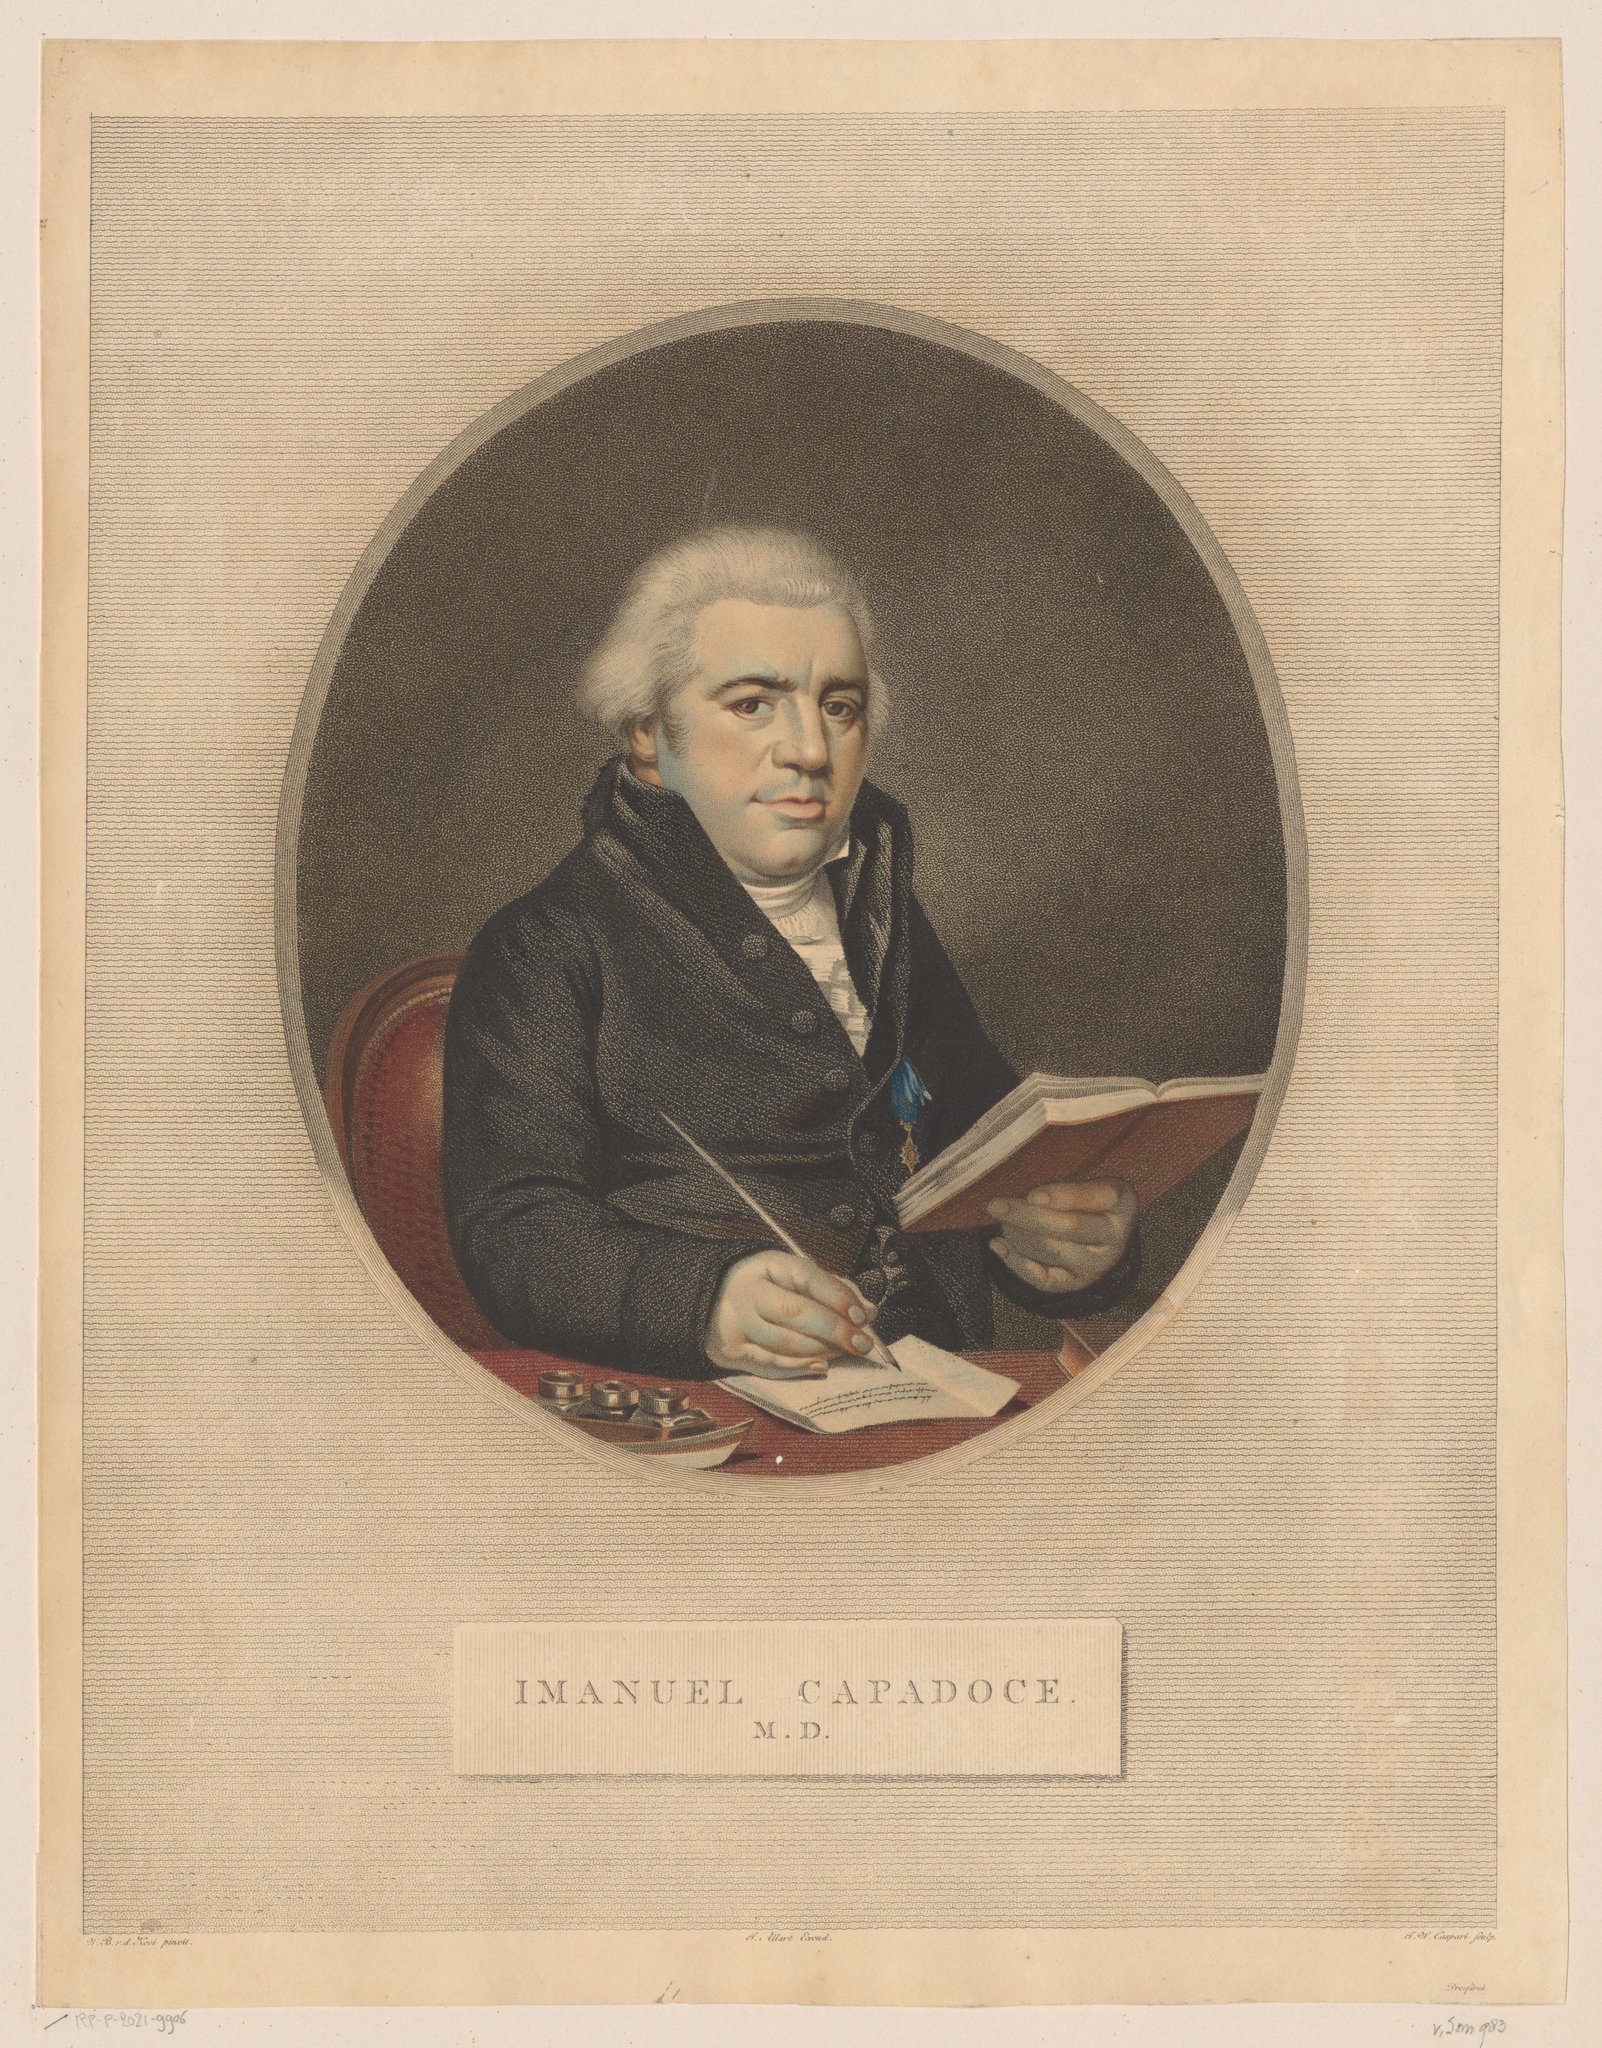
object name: print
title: Portret van Immanuel Capadose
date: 1789-1816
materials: paper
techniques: etching, hand coloring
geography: amsterdam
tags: amsterdam, historical persons